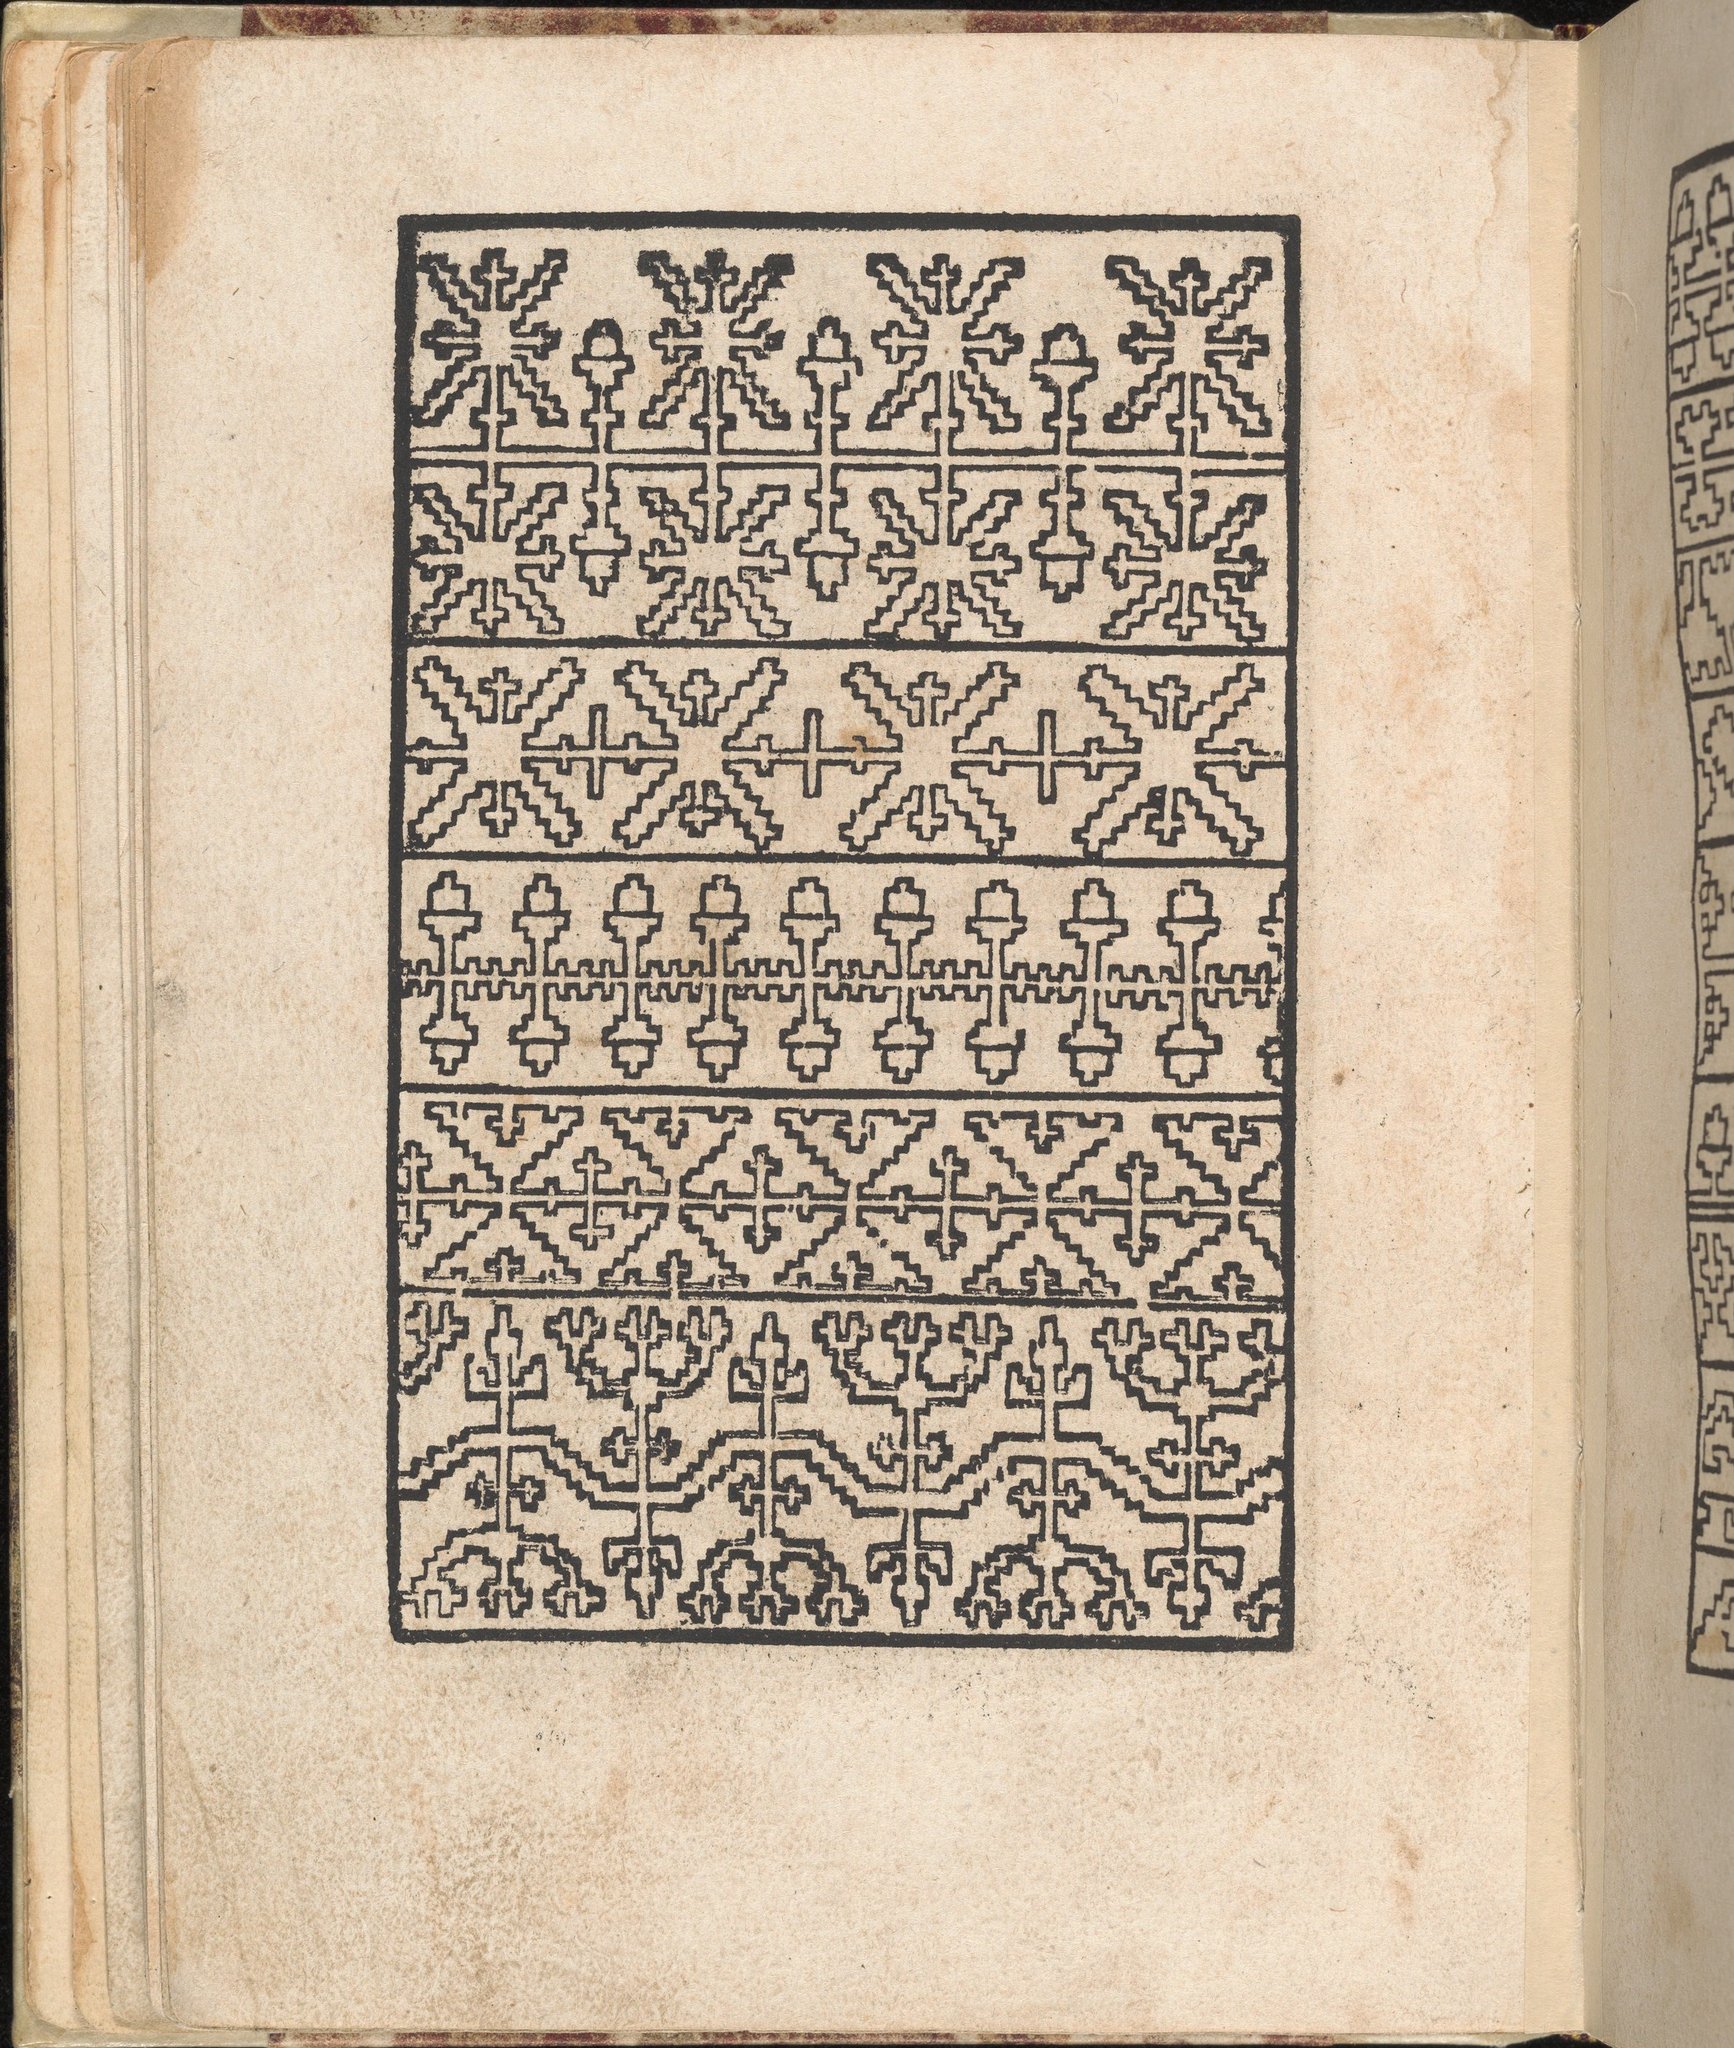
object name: book print ornament architecture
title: Ein new getruckt model Büchli...Page 19, recto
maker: johann schönsperger the younger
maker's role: publisher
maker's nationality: german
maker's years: 1490-1550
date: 1529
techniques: woodcut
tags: ornament